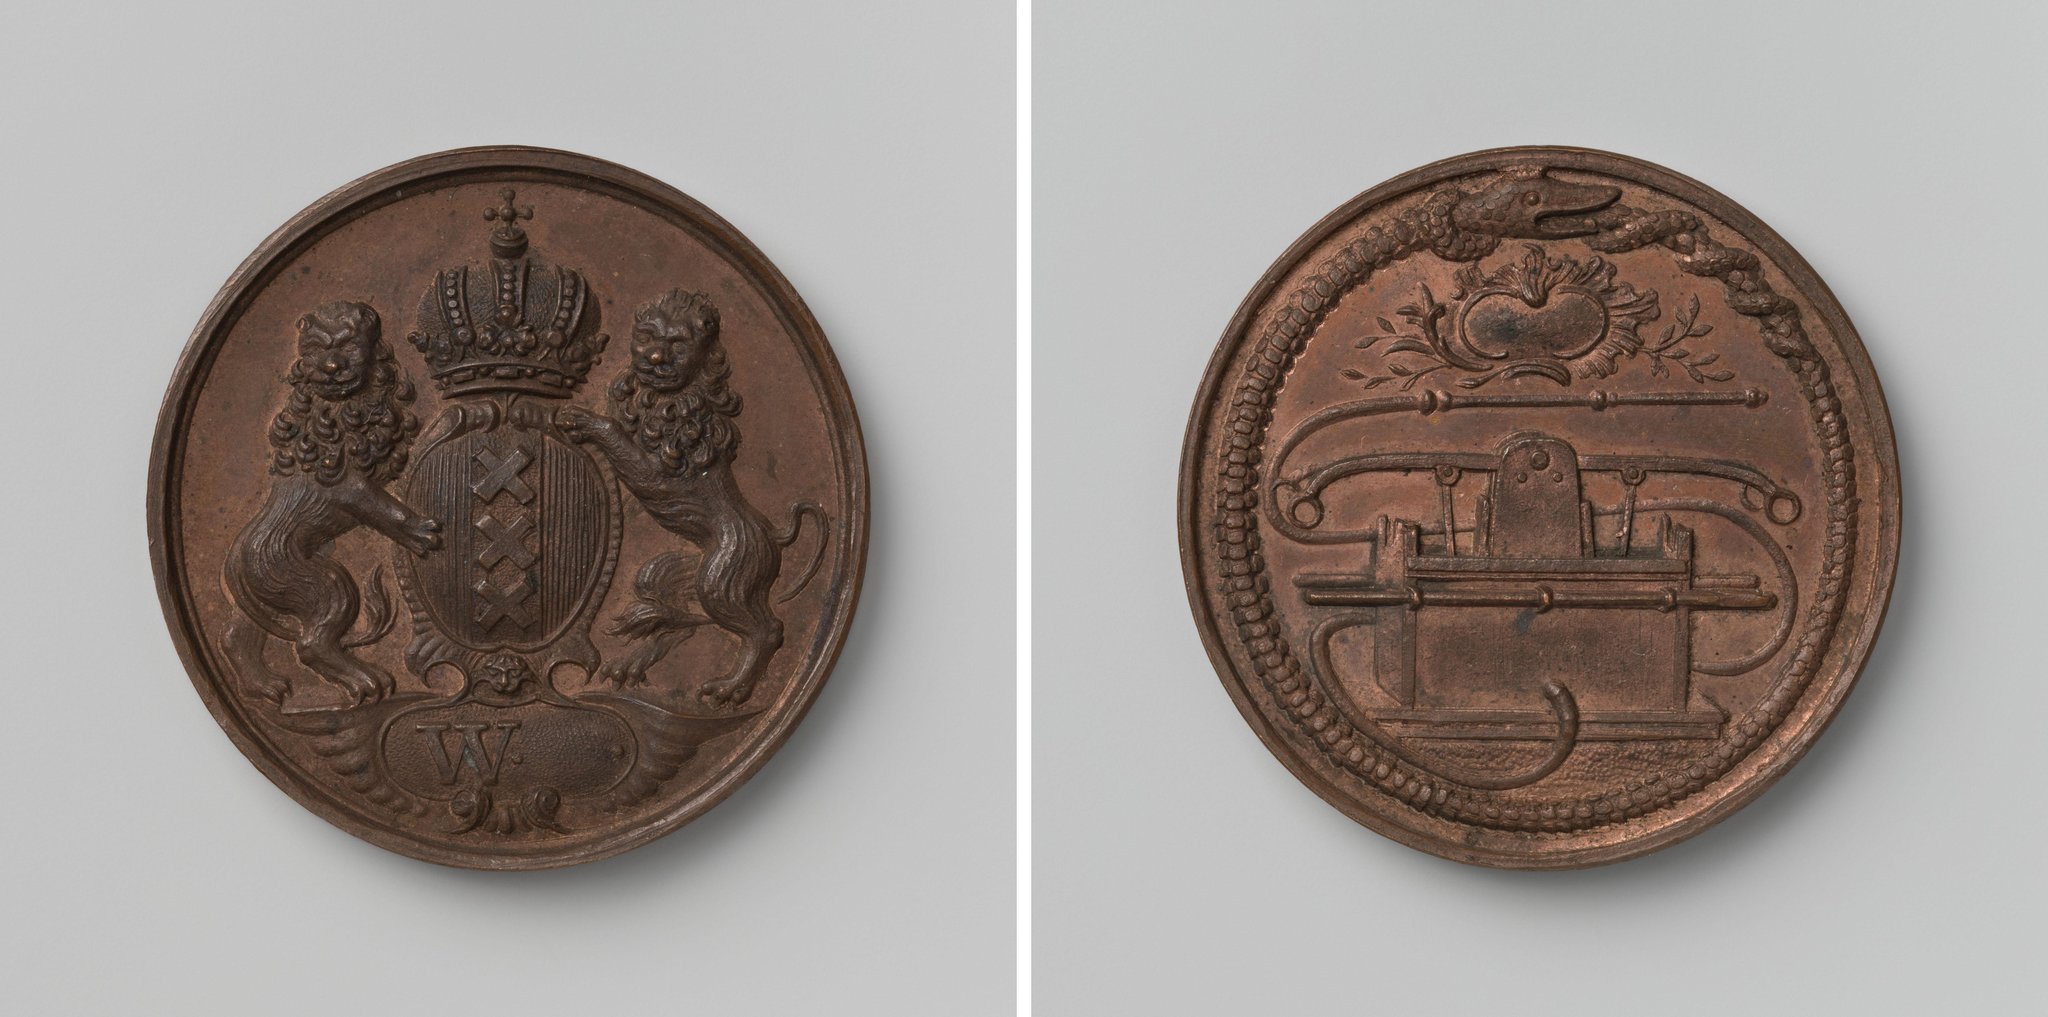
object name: fire engine medal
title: Amsterdam, brandspuitpenning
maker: Anonymous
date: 1680-1800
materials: bronze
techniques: engraving, striking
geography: amsterdam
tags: amsterdam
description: Bronzen penning. Voorzijde: gekroond wapenschild, geflankeerd door twee leeuwen boven cartouche met opschrift W. Keerzijde: brandspuit onder leeg cartouche versierd met bladertakken binnen slangerond